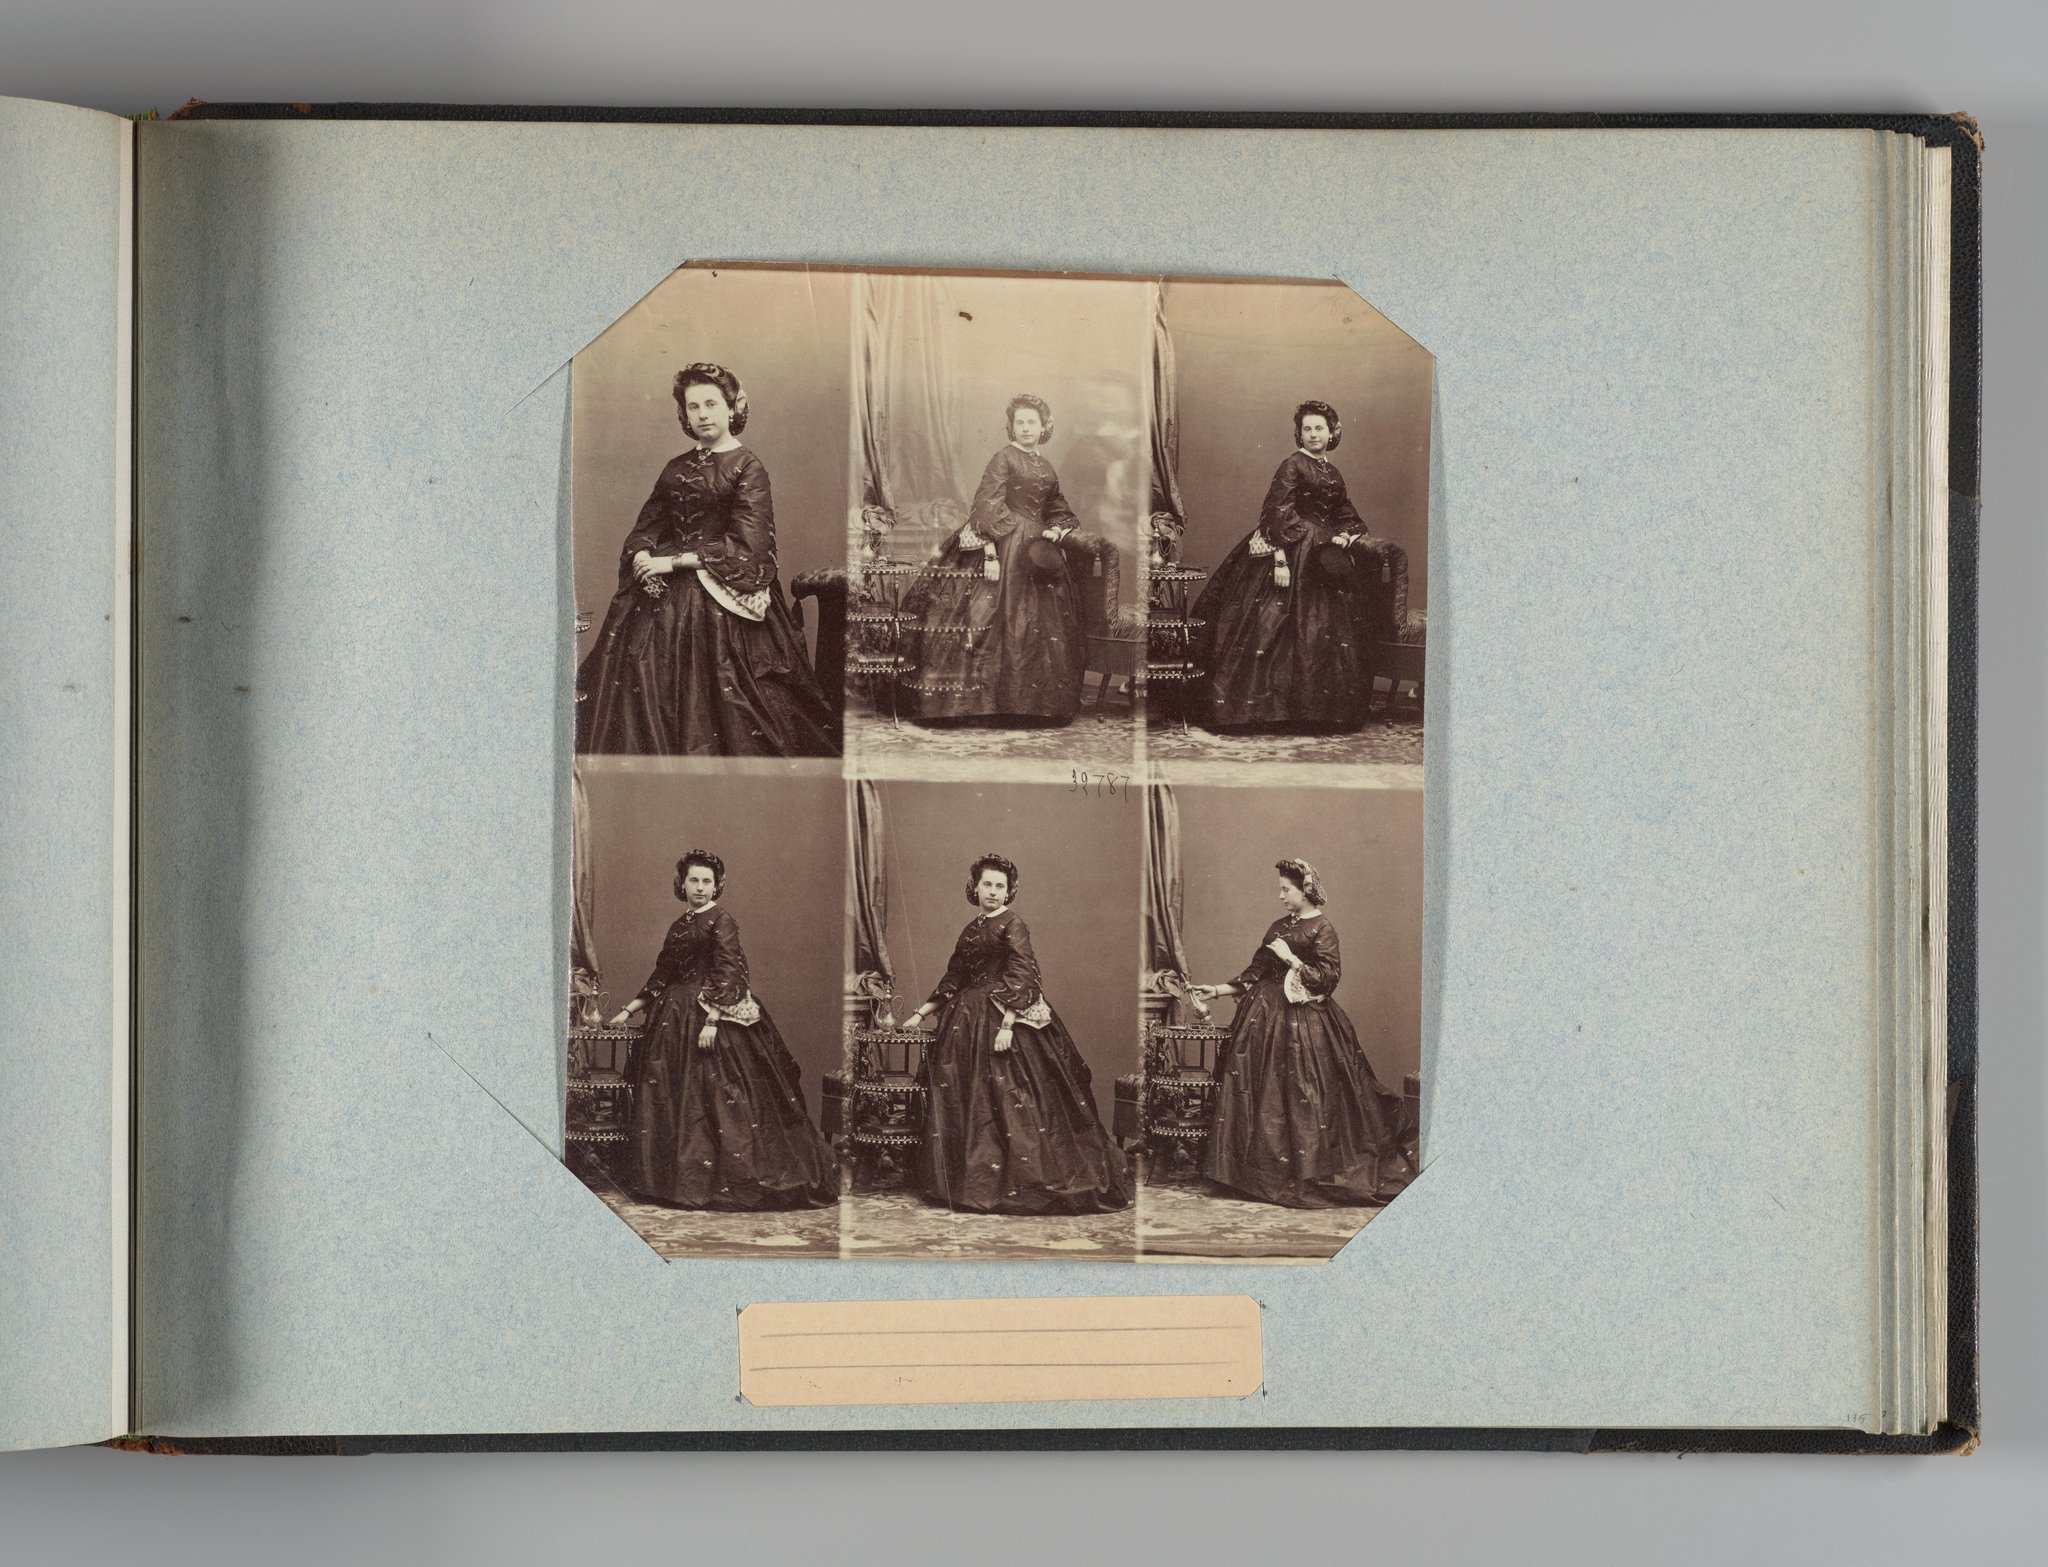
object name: photograph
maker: andré-adolphe-eugène disdéri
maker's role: artist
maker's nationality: french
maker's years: 1819-1889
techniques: albumen silver print, glass negative